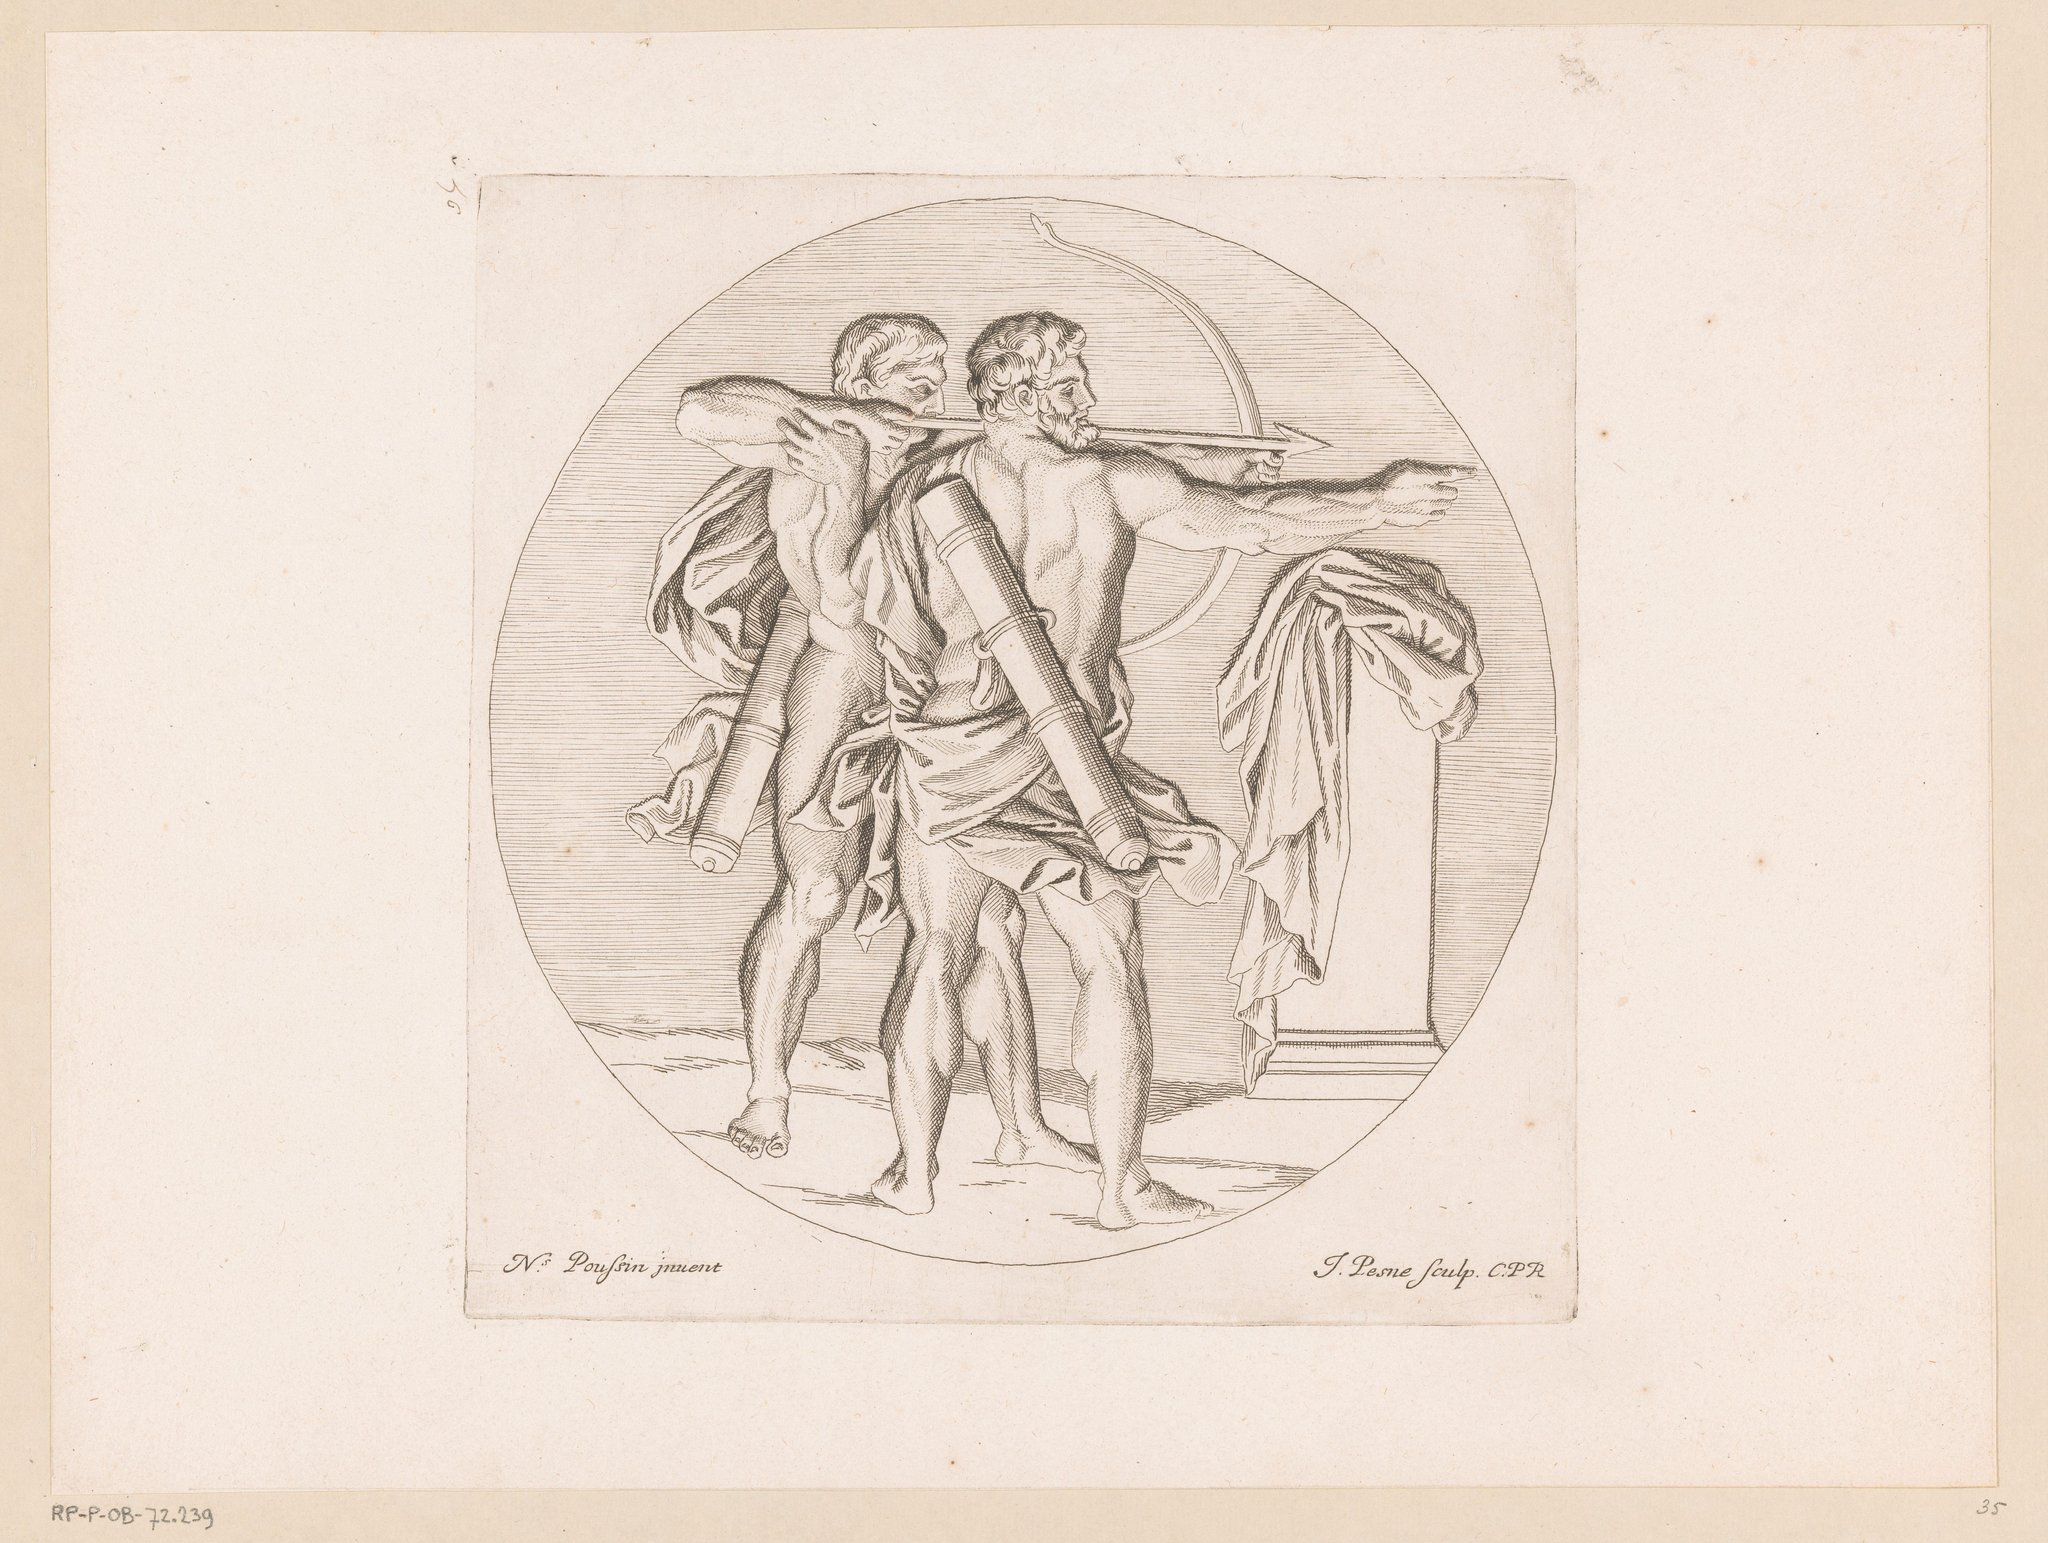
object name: print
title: Chiron leert Hercules boogschieten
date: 1678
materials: paper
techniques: engraving, etching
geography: france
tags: chiron instructing hercules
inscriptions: collector's mark: Lugt 240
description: Prent maakt deel uit van een ongenummerde serie van negentien prenten.